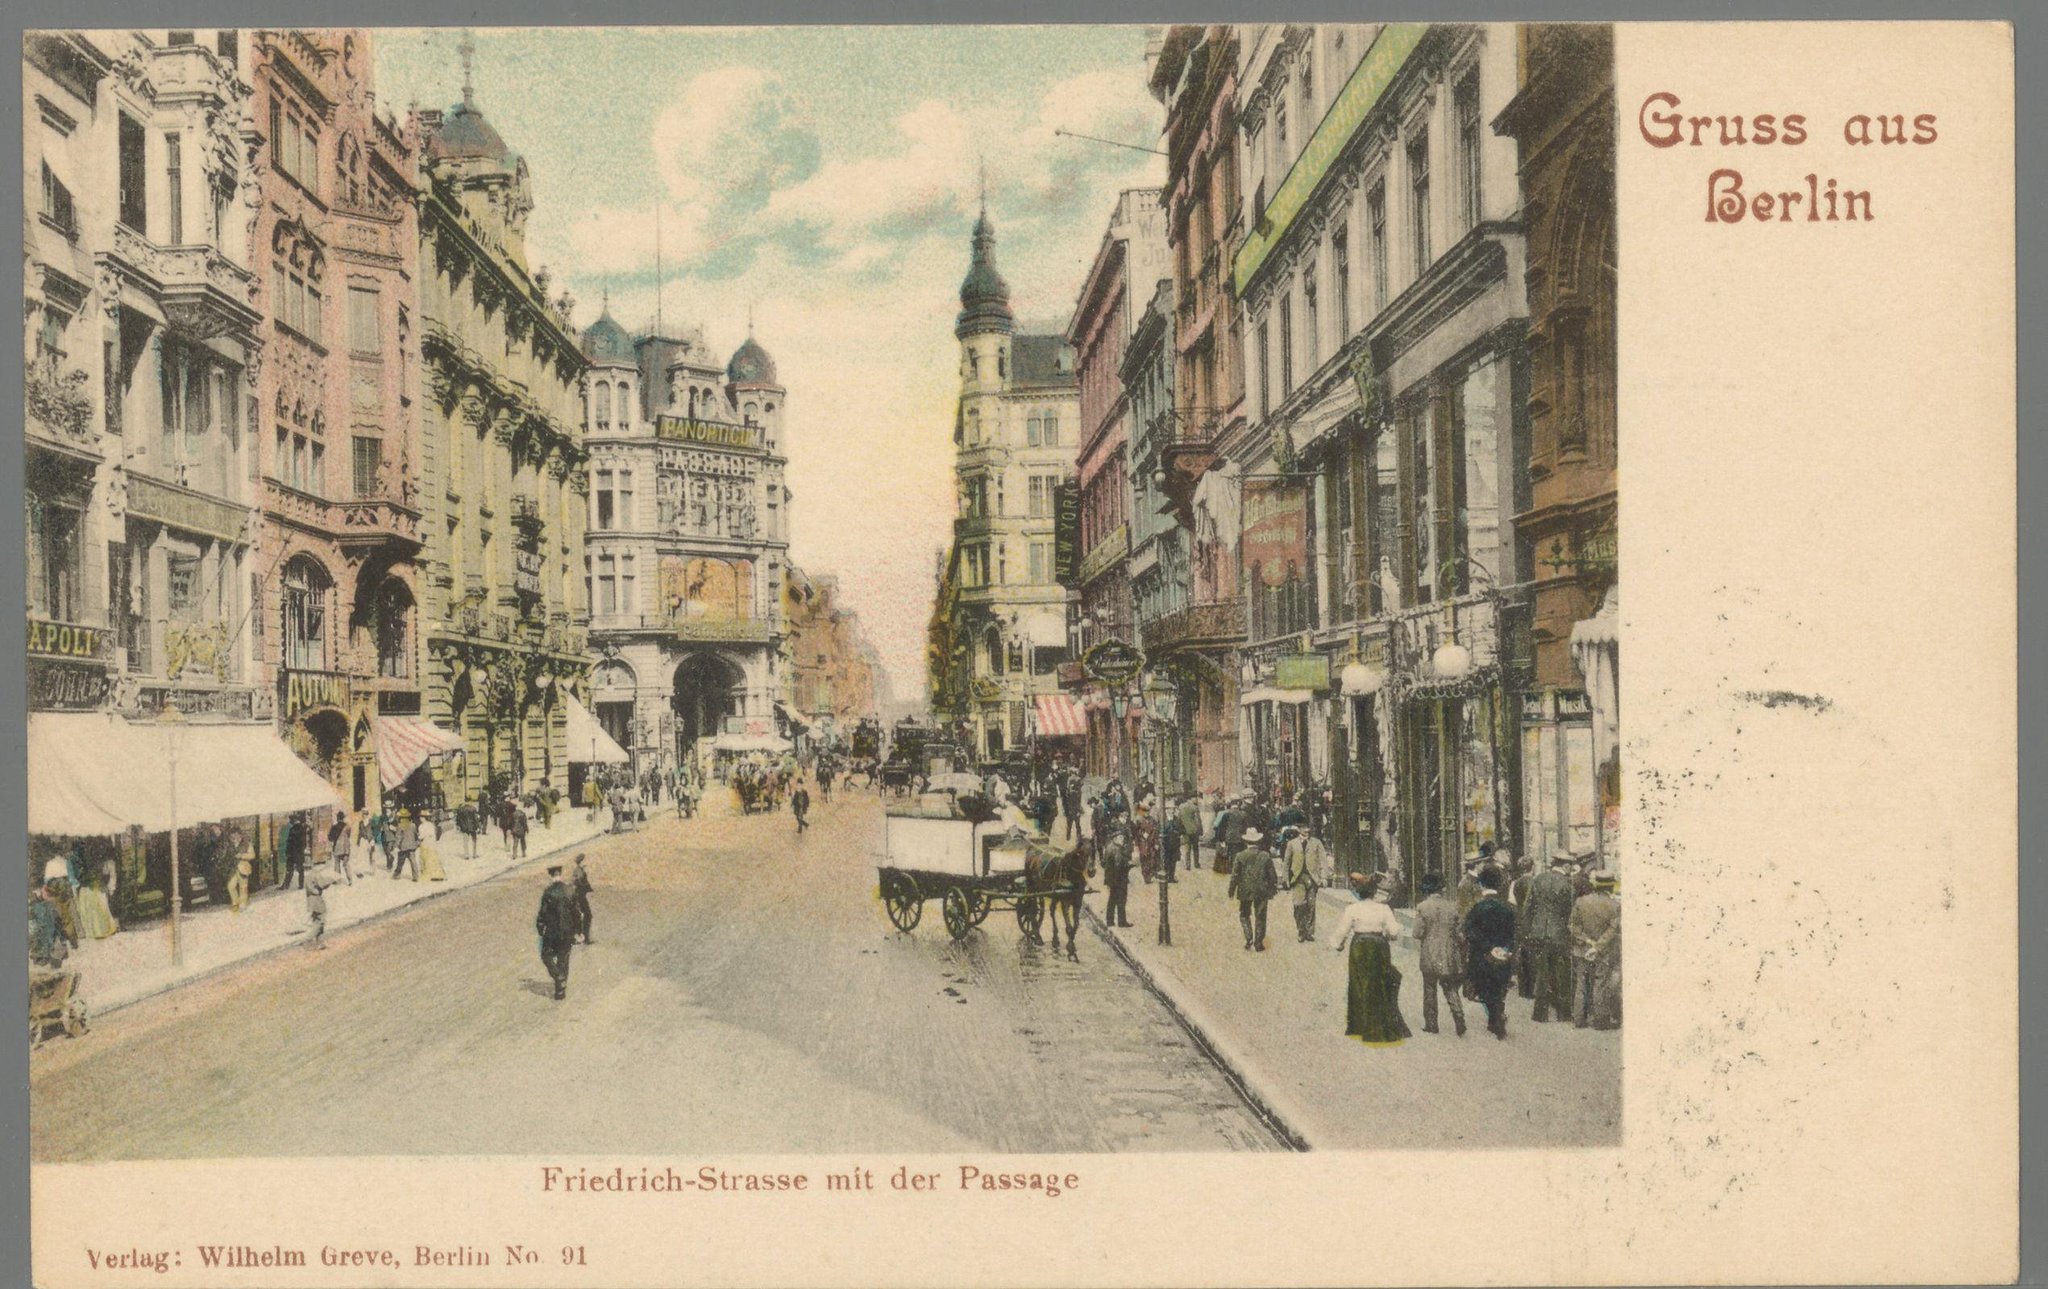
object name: photomechanical print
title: Gruss aus Berlin. Friedrich-Strasse mit der Passage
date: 1890-1903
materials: cardboard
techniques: photograph, lithograph, writing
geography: berlin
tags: buildings for performances, street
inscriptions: postage stamp